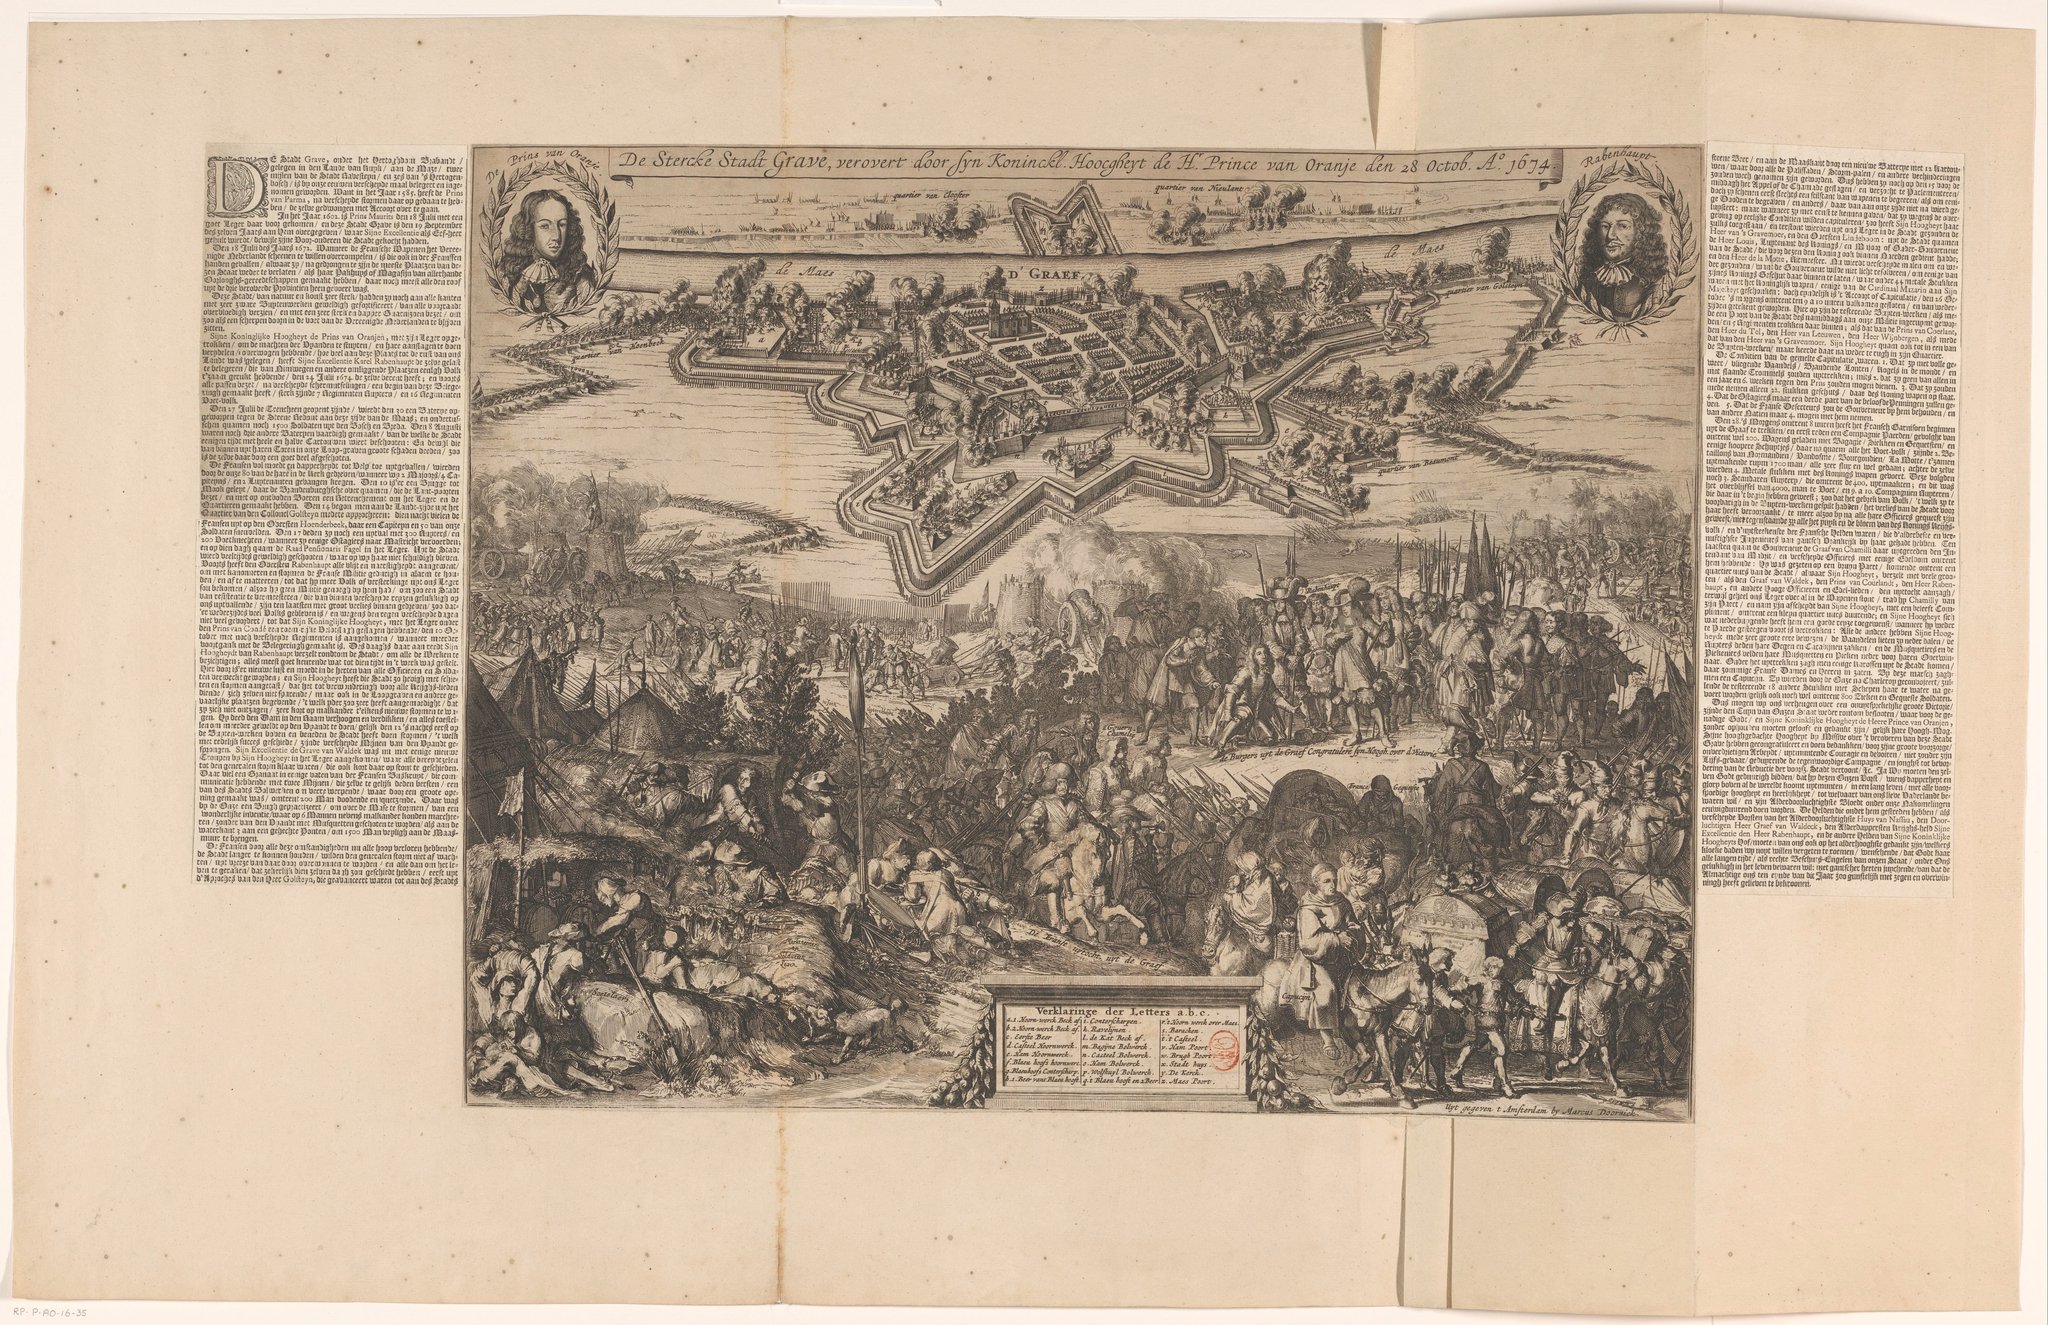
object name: print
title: Verovering van Grave door Willem III, 1674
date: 1674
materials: paper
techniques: engraving, etching, letterpress printing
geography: amsterdam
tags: the hague, william iii (prince of orange and king of england, scotland, and ireland), siege, position war, capture of city (after the siege), grave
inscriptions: collector's mark: Lugt 195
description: Beleg en verovering van Grave door Willem III, 25 juli tot 29 oktober 1674. Boven een gezicht op de belegerde stad met aan weerszijden medaillons met portretten van Willem III en Rabenhaupt. Onder verlaten de Fransen de veroverde stad en knielen vertegenwoordigers van de stad voor de prins. Links scènes uit het leven in een legerkamp. Onderaan een cartouche met de legenda a-z. In de voorstelling meerdere opschriften, waarvan sommige onvoltooid of weggepolijst zijn. Aan weerszijden van de prent tekstbladen met tekst over de belegering van de stad.